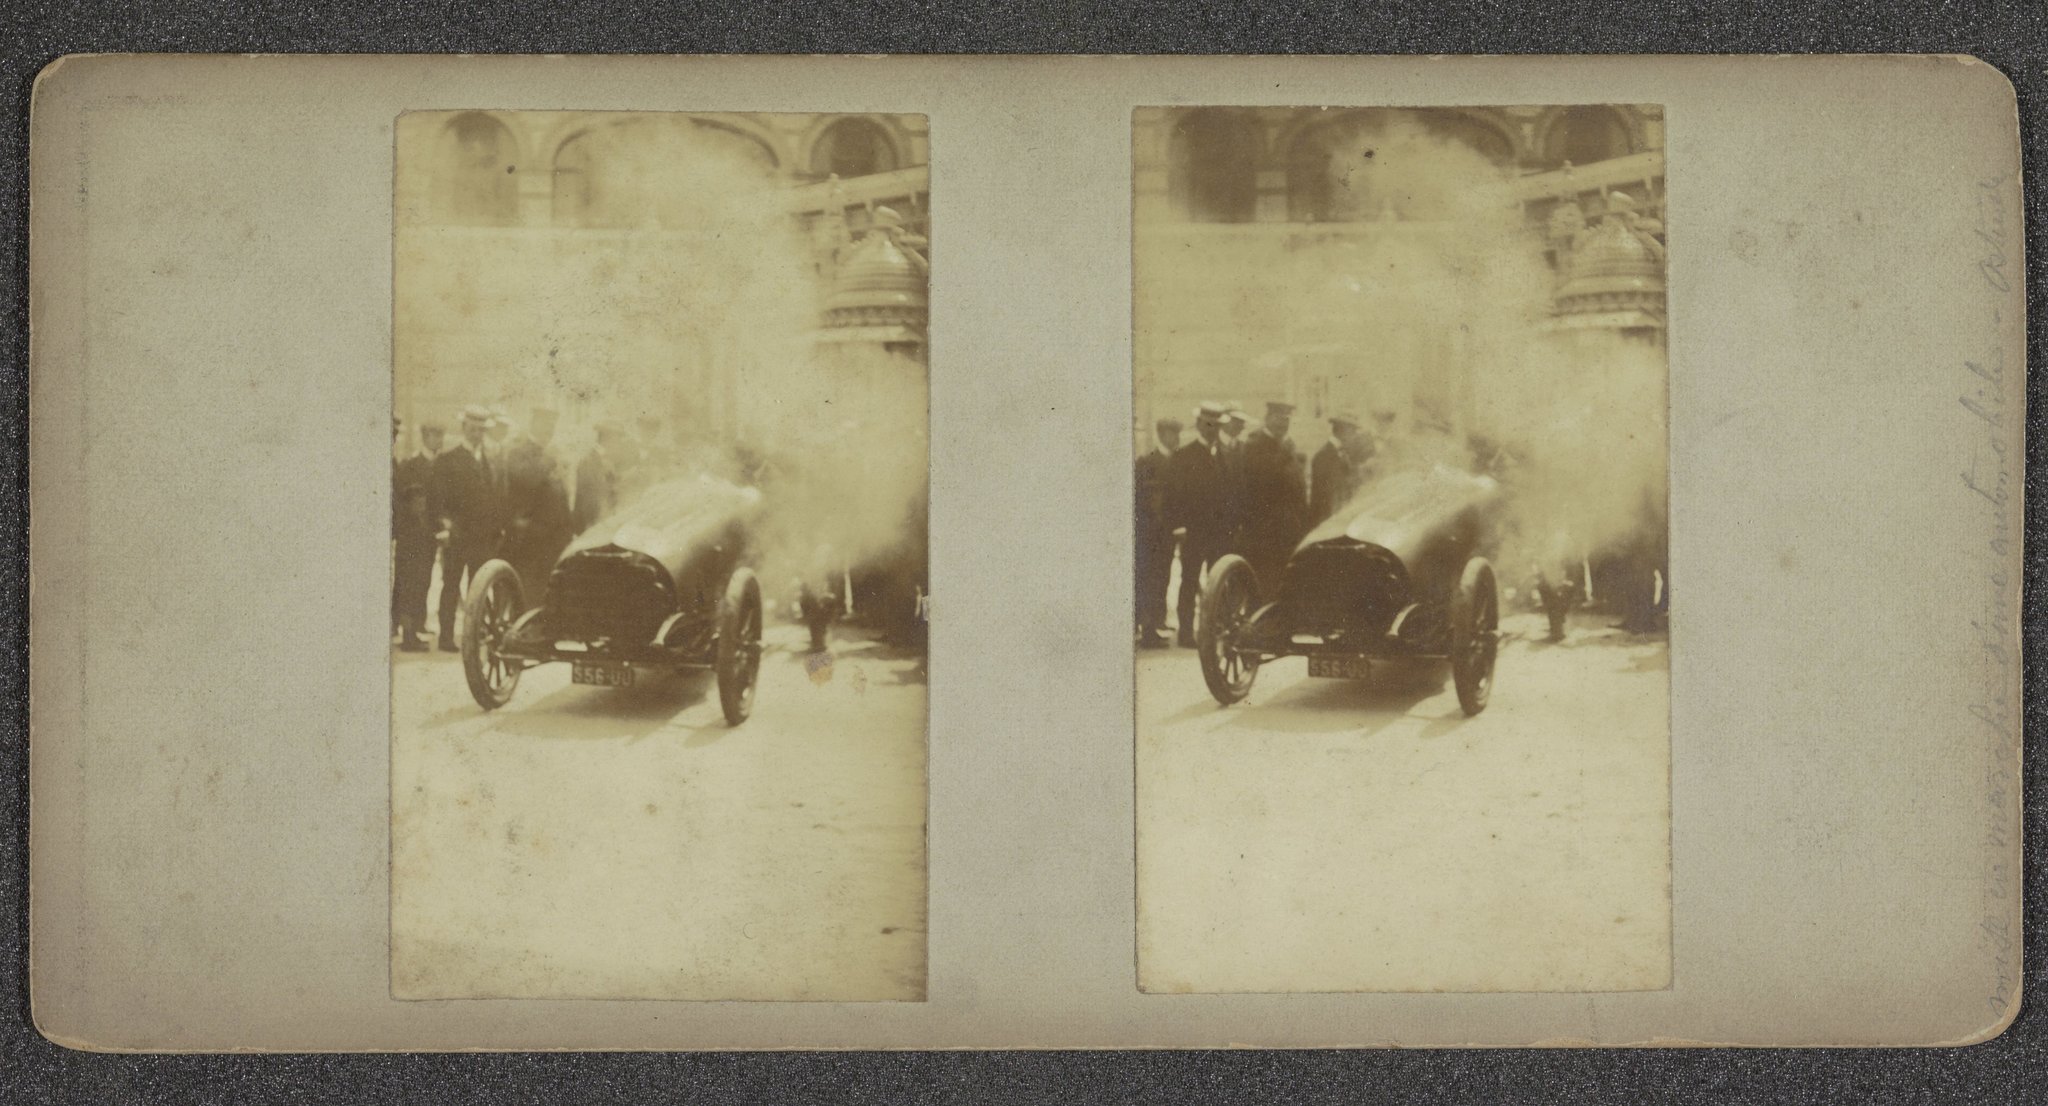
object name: photograph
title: mise en marche d'une automobile Ostende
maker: Anonymous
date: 1904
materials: cardboard, paper, photographic support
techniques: gelatin silver print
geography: oostende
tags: trade exhibition, industries fair, automobile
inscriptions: title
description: De stereofoto is genomen voor de Kursaal van Oostende, aan de zijde van de zee, namelijk op de Albert I-promenade op 21 juli 1904, op de laatste dag van de festiviteitenweek "la semaine d'Ostende" van 14 tot en met 21 juli 1904. De hier afgebeelde auto is de Clément-Bayard die bestuurd werd door Hanriot.